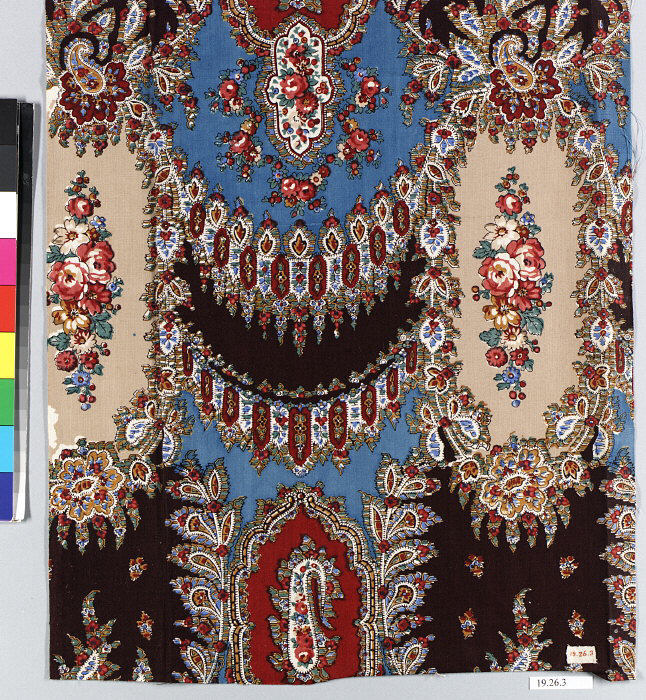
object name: sample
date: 1840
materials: cotton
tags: flowers